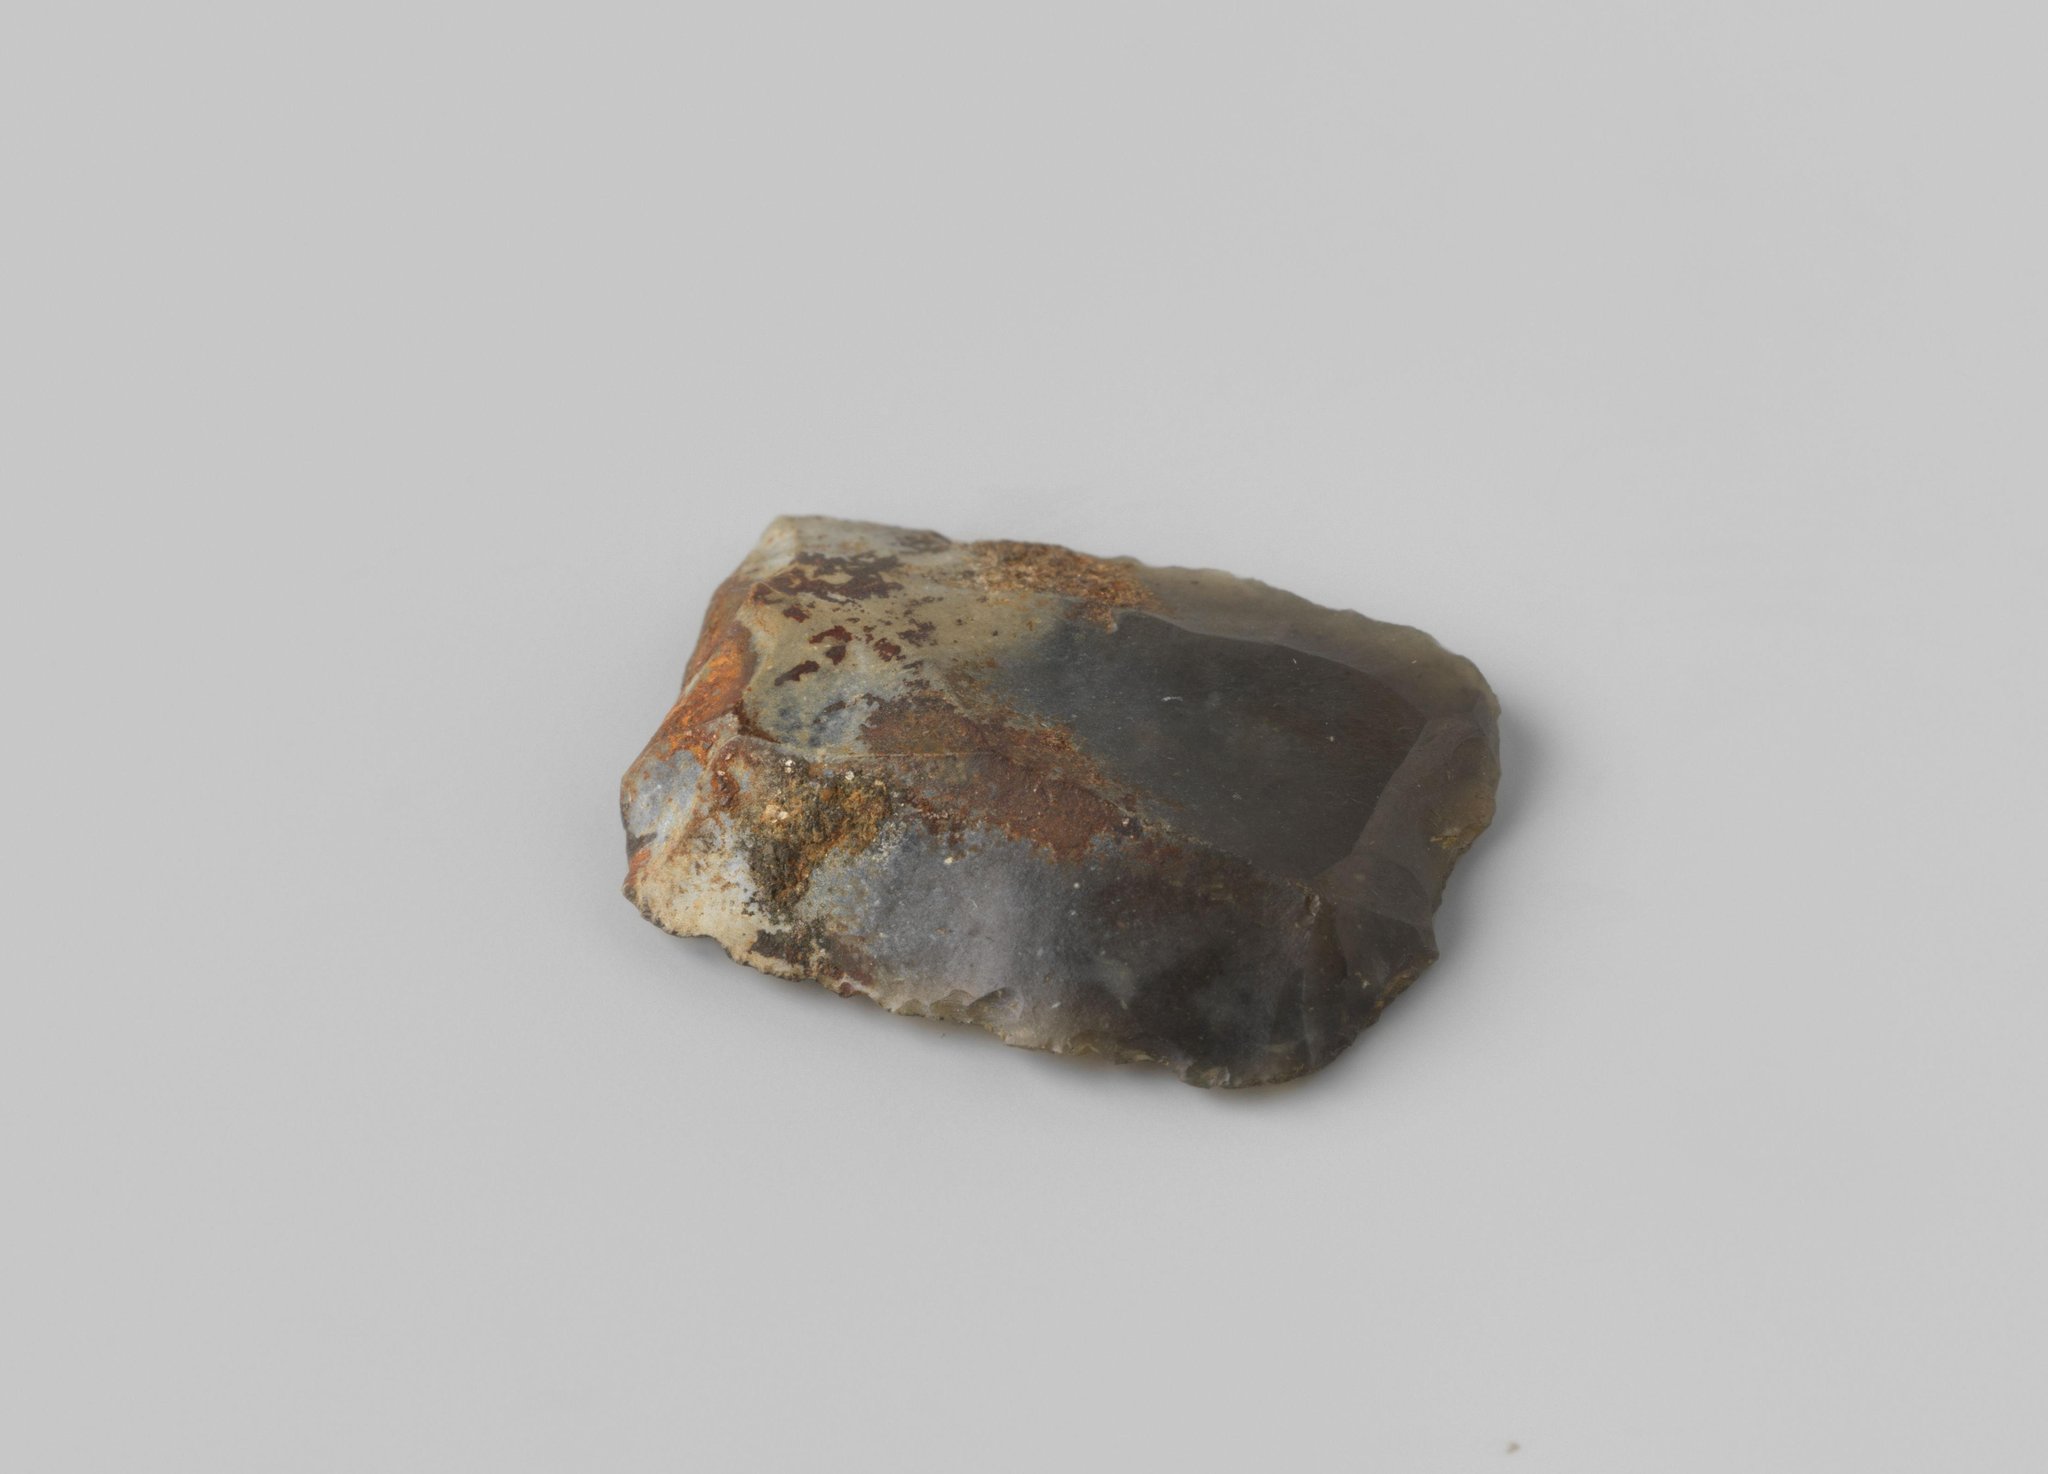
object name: flint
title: Vuursteen uit het wrak van de Oost-Indiëvaarder Hollandia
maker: Anonymous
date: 1700-1743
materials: stone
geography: netherlands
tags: verenigde oostindische compagnie, hollandia (schip), annet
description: Oblong, rounded heel, flat oblique top face, bevelled sides, flint.